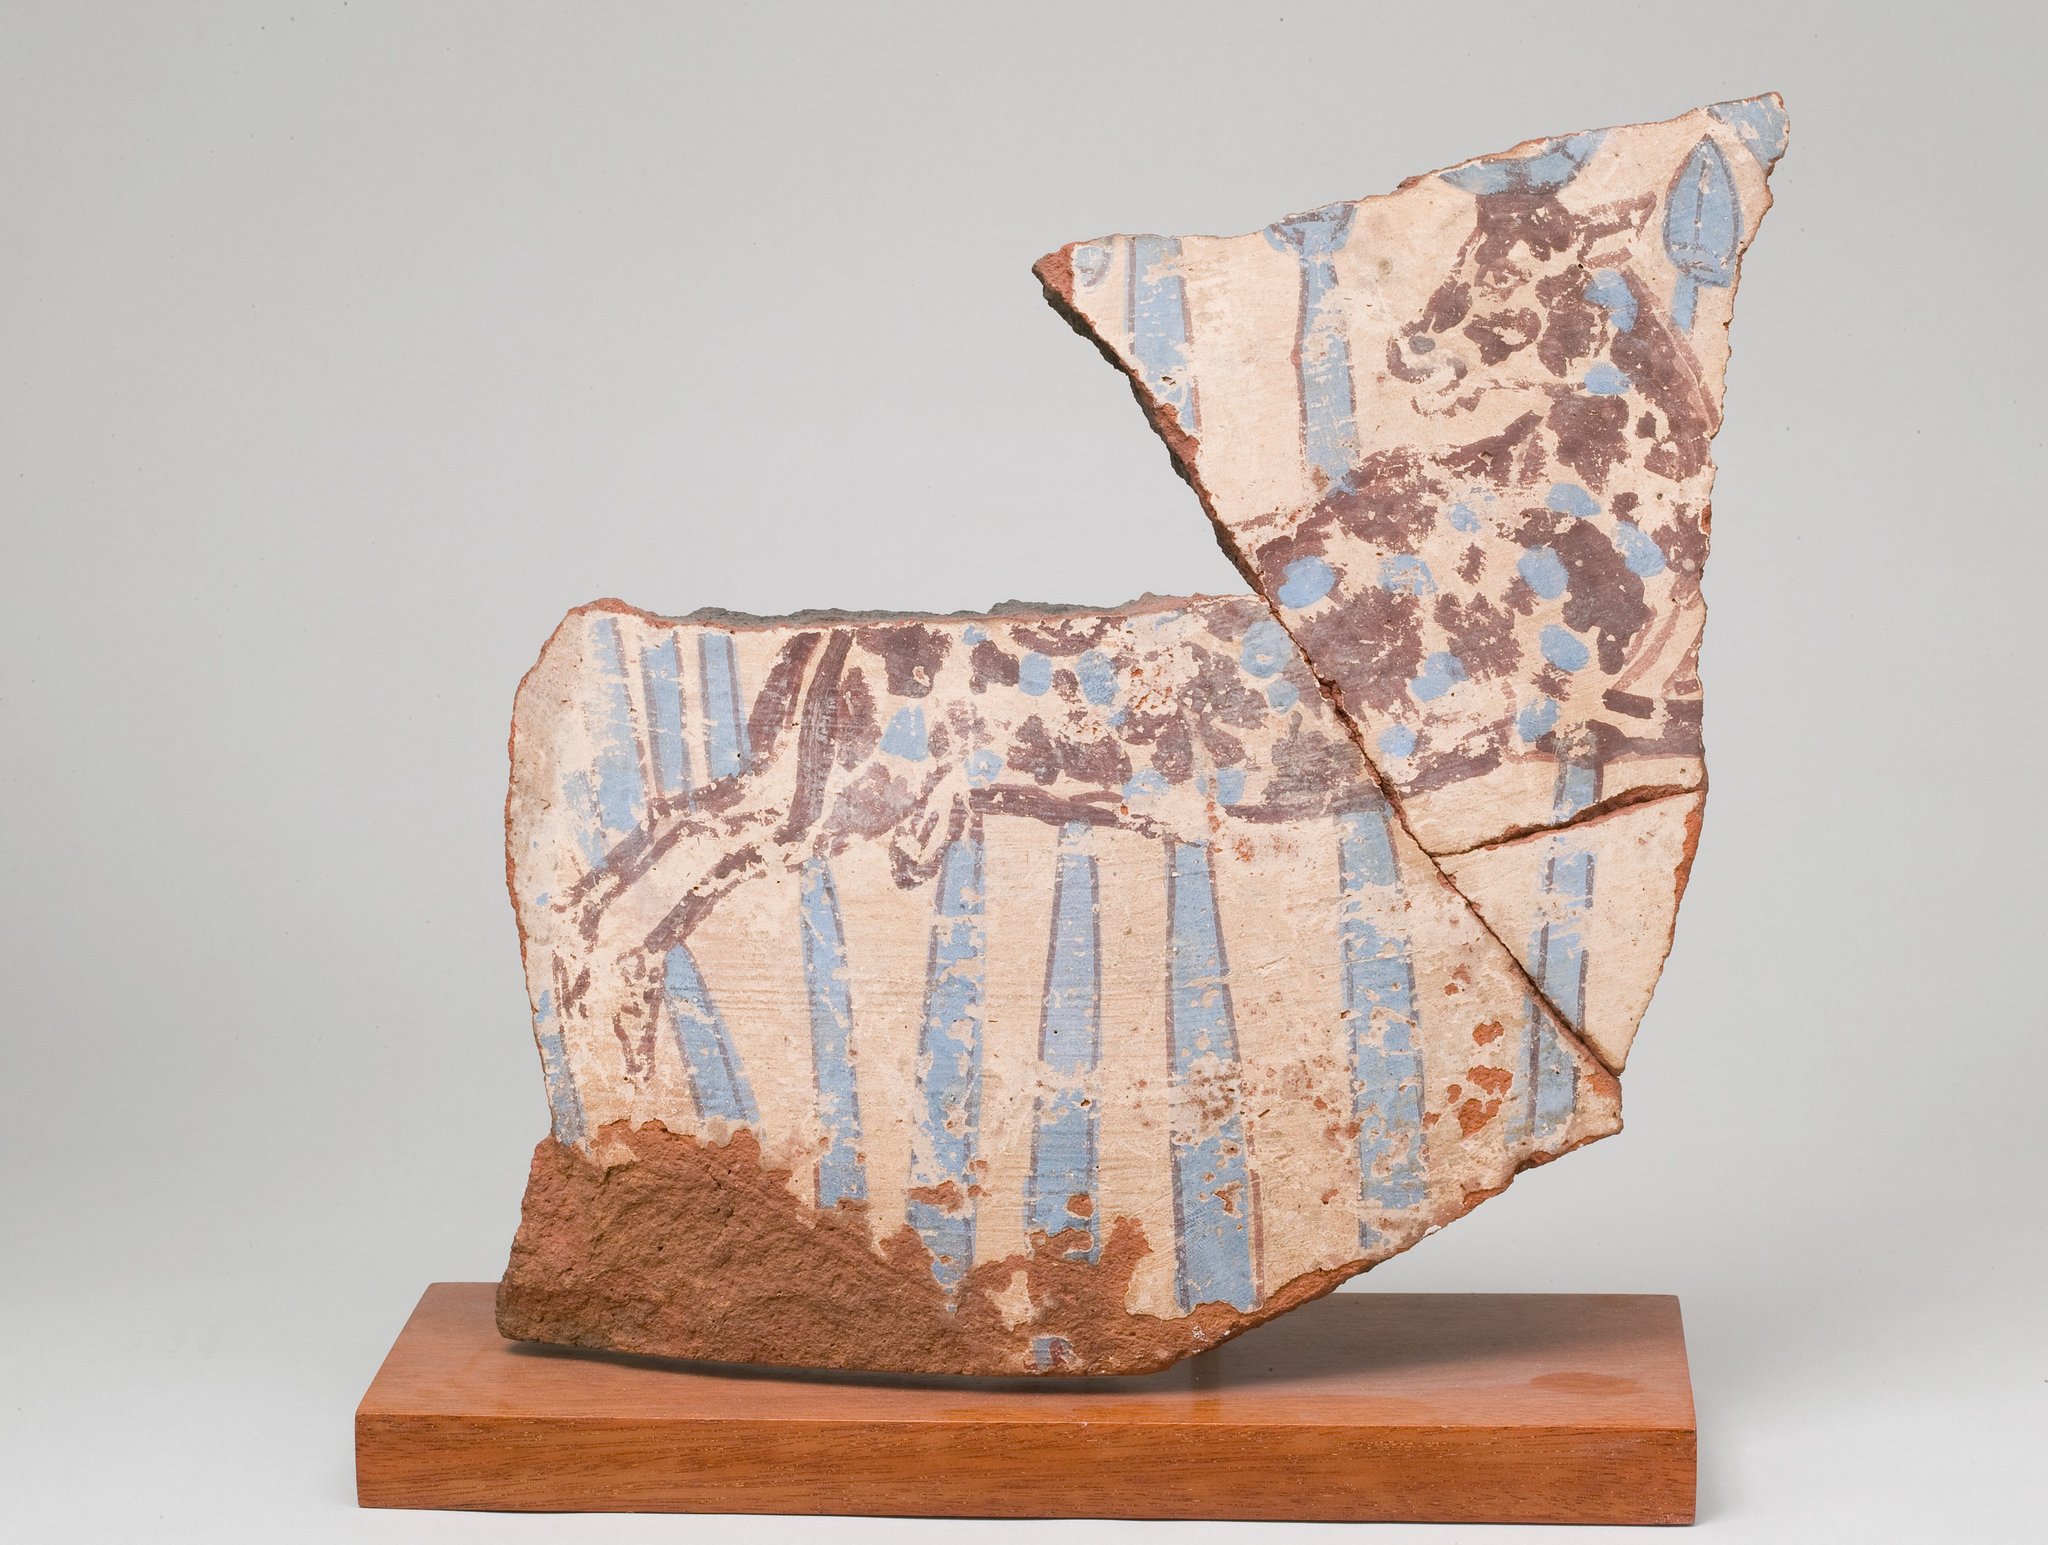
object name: blue painted jar fragment, bull leaping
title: Blue-Painted Jar Fragment from Malqata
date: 1390-1352 BCE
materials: paint, pottery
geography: egypt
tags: cows